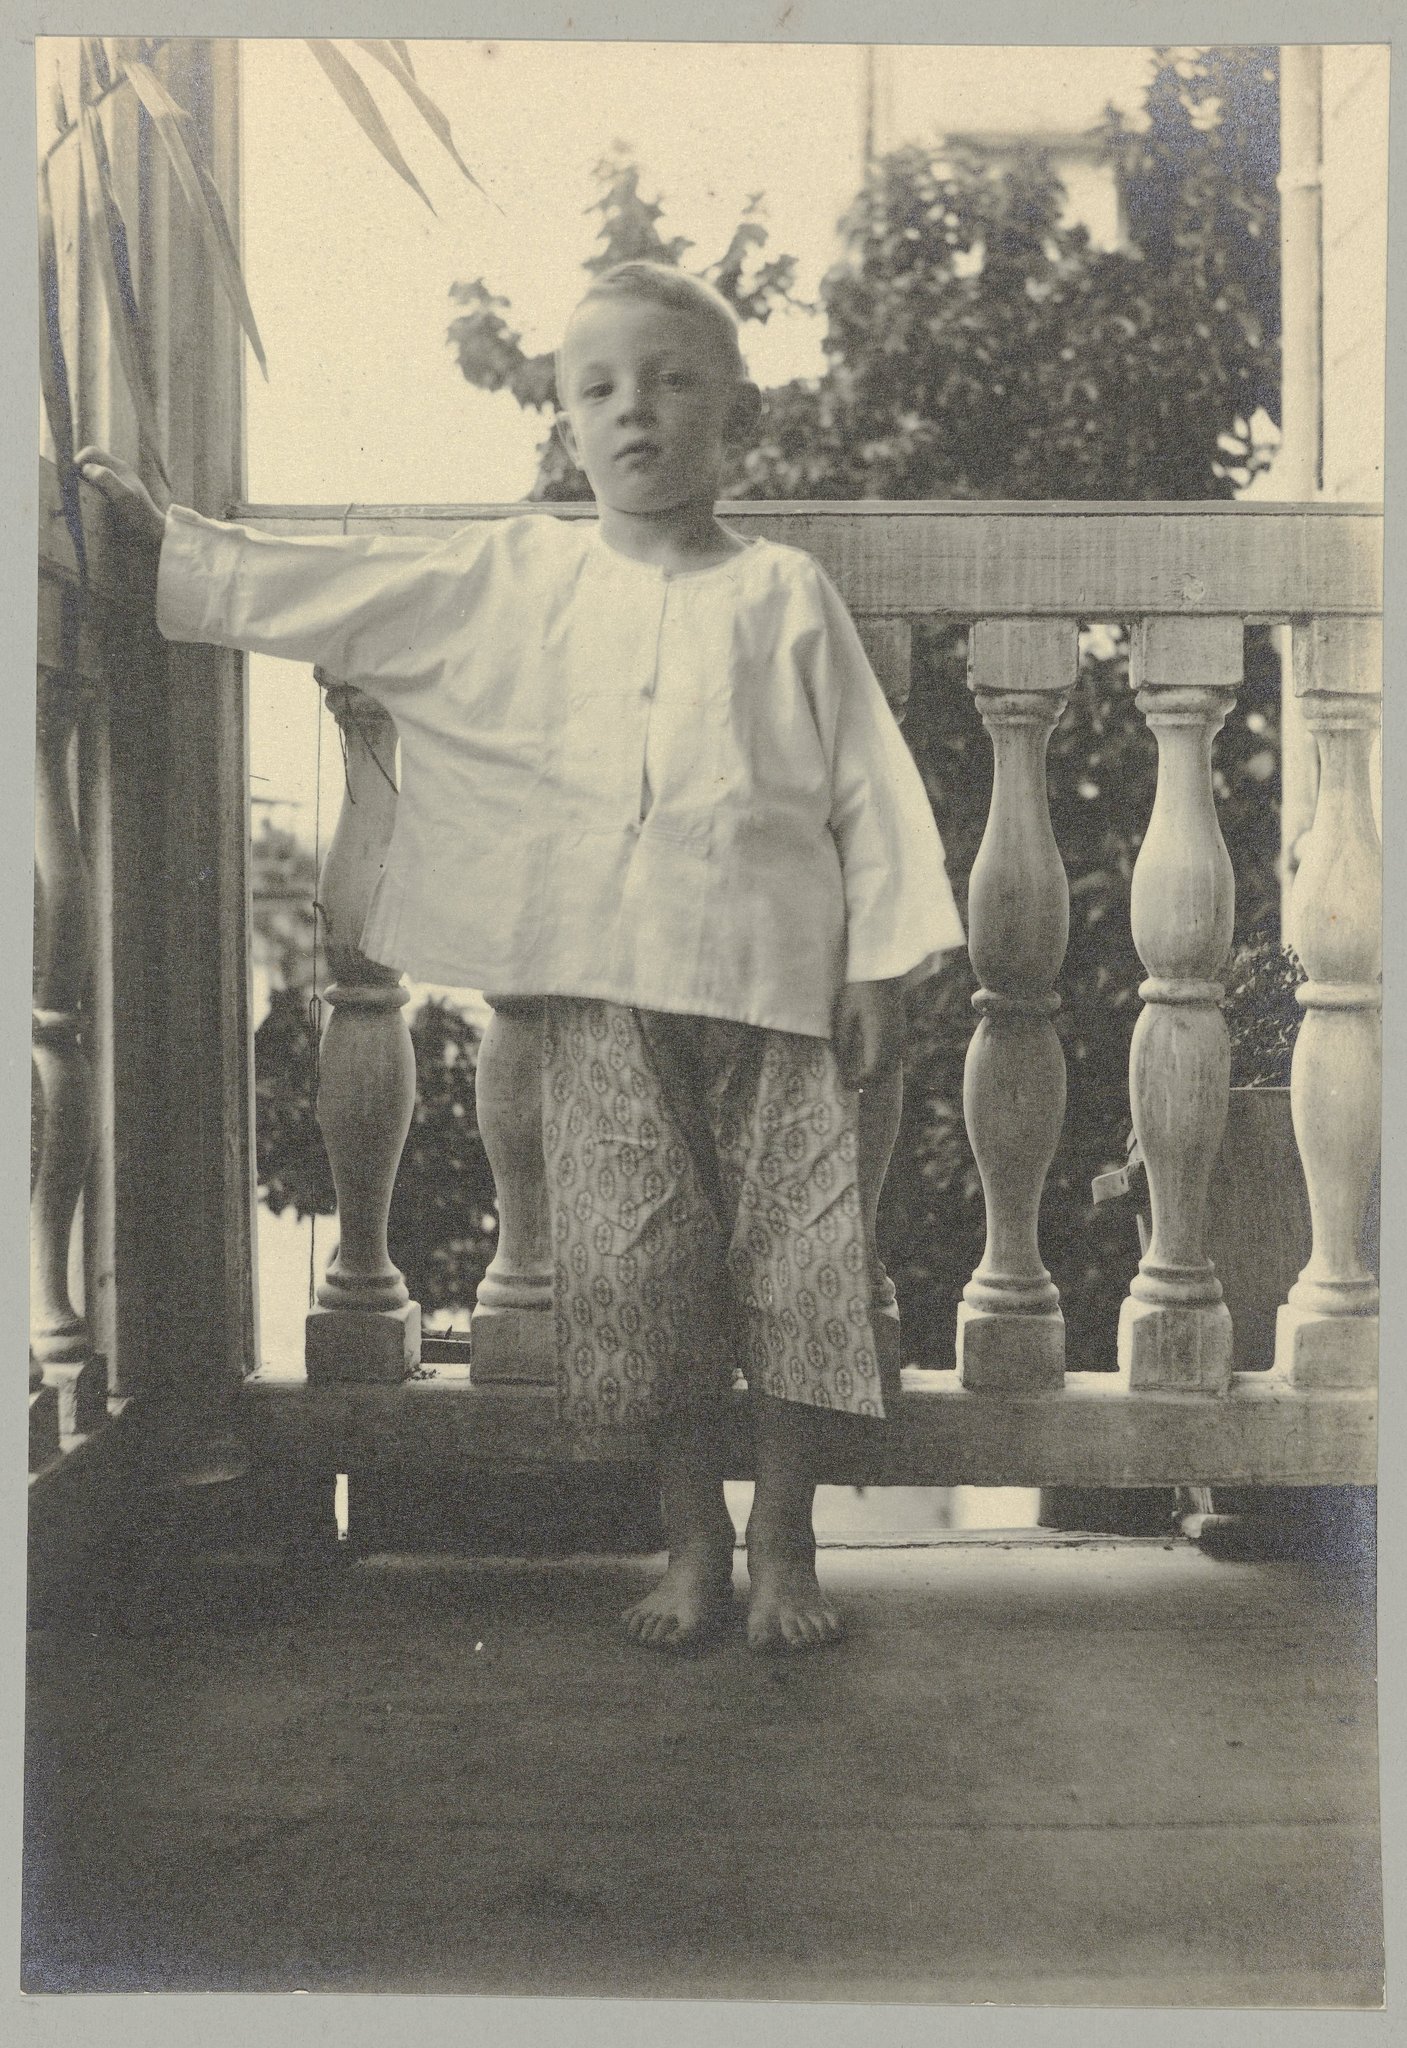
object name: photograph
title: Pim op balkon Oranjestraat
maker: hendrik doijer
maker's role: engineer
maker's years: 1863-1925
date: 1903-1910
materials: photographic support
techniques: gelatin silver print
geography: suriname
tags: suriname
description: De Nederlandse jongen genaamd Pim poserend op het balkon van het familiehuis in de Oranjestraat te Paramaribo. Onderdeel van het fotoalbum Souvenir de Voyage (deel 4), over het leven van de familie Doijer in en rond de plantage Ma Retraite in Suriname in de jaren 1903-1910.